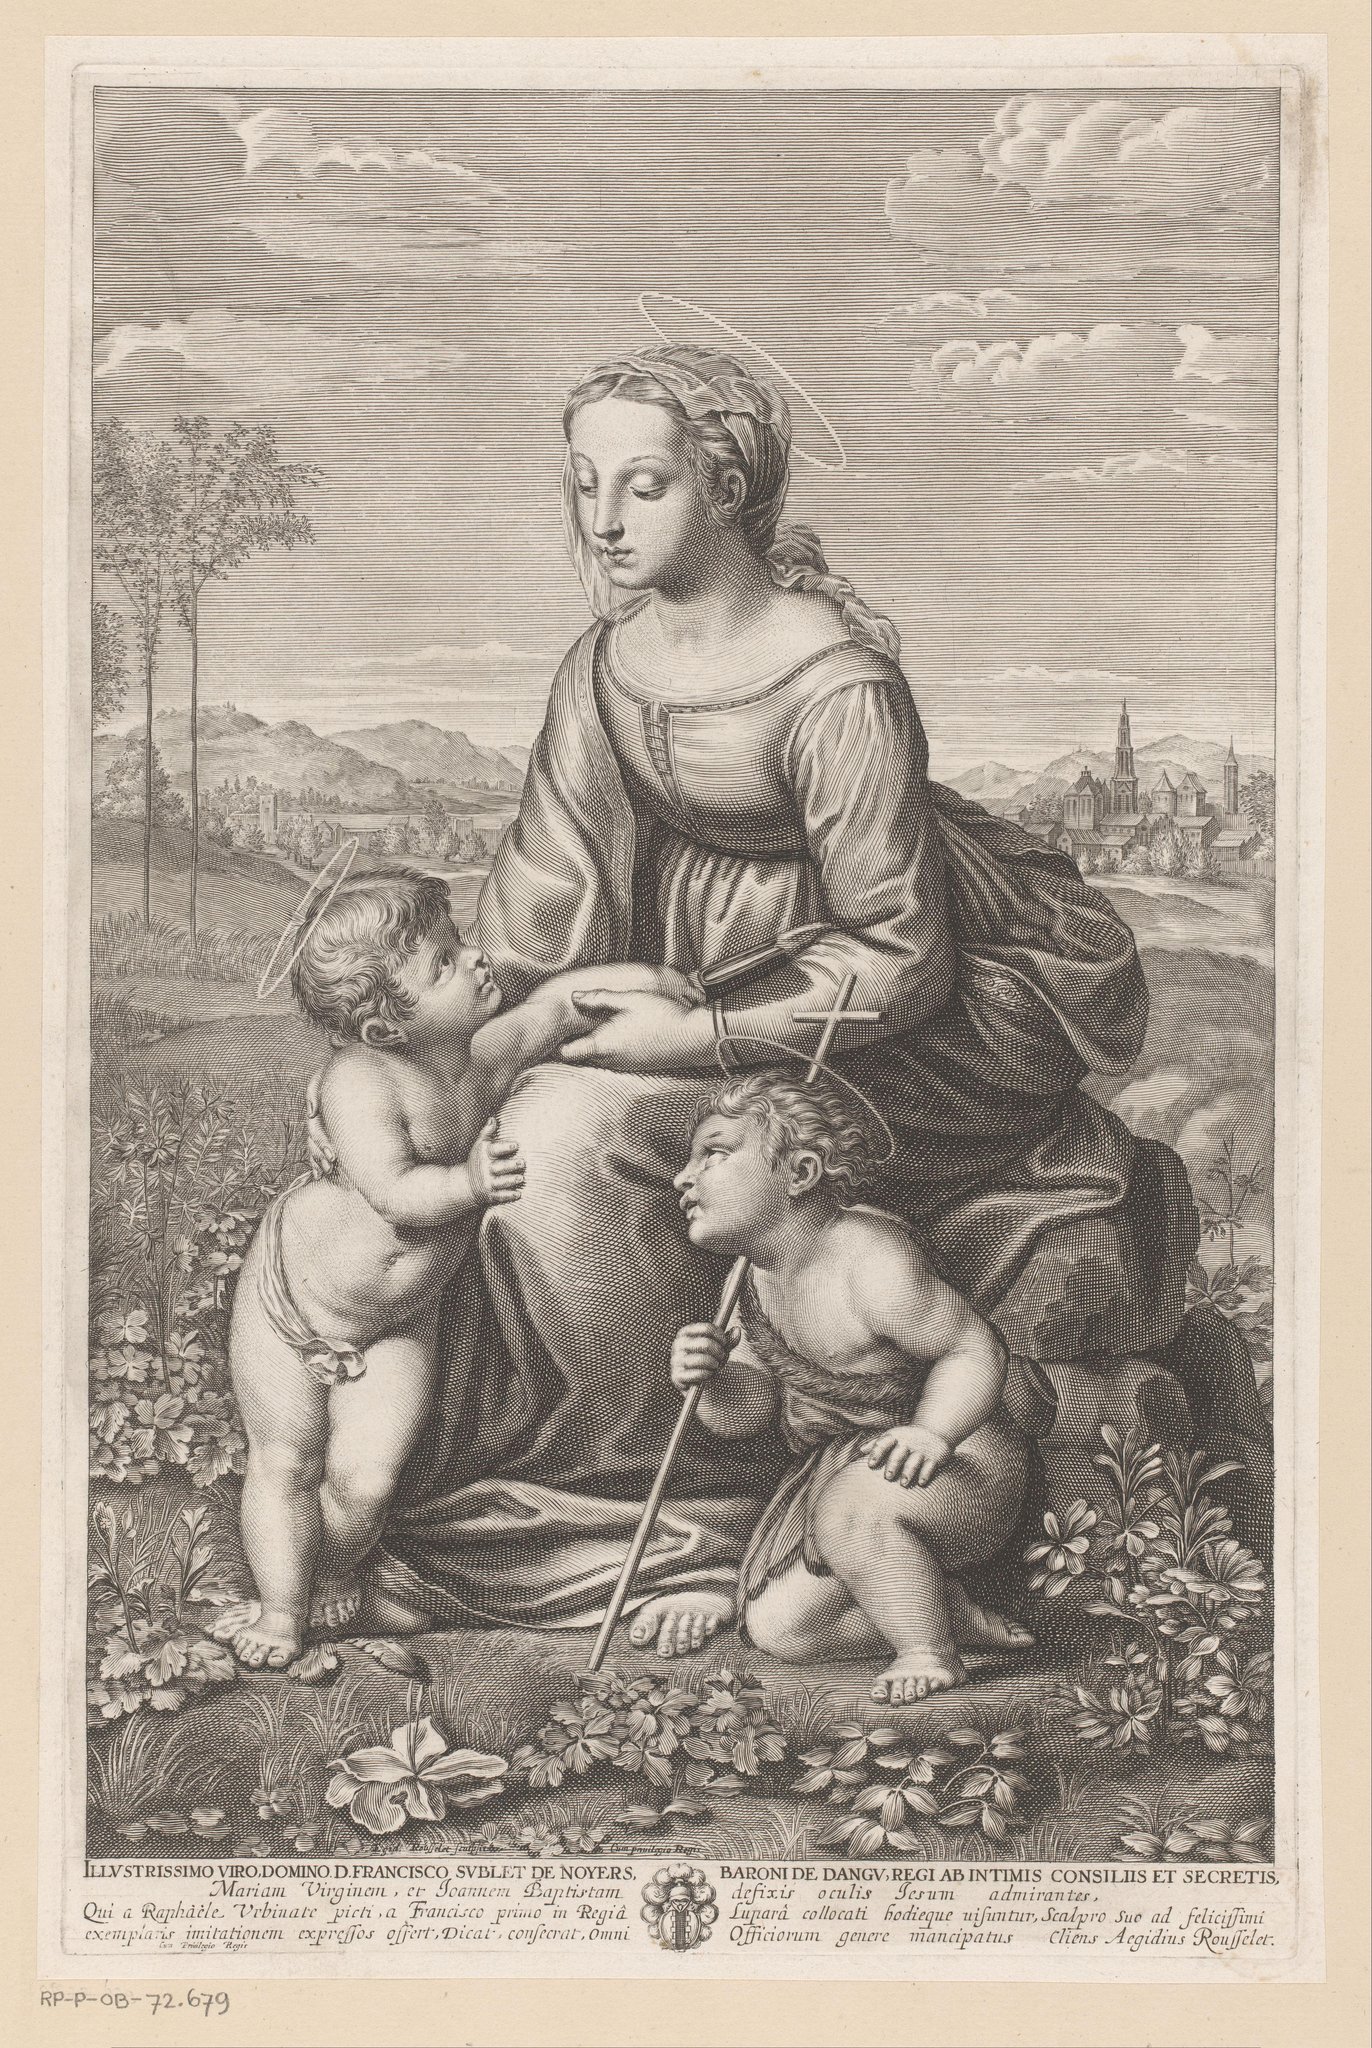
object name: print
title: Maria met kind en Johannes de Doper in weidelandschap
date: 1640-1644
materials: paper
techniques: engraving, etching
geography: france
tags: mary and the christ-child with john the baptist (as child)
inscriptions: collector's mark: Lugt 240